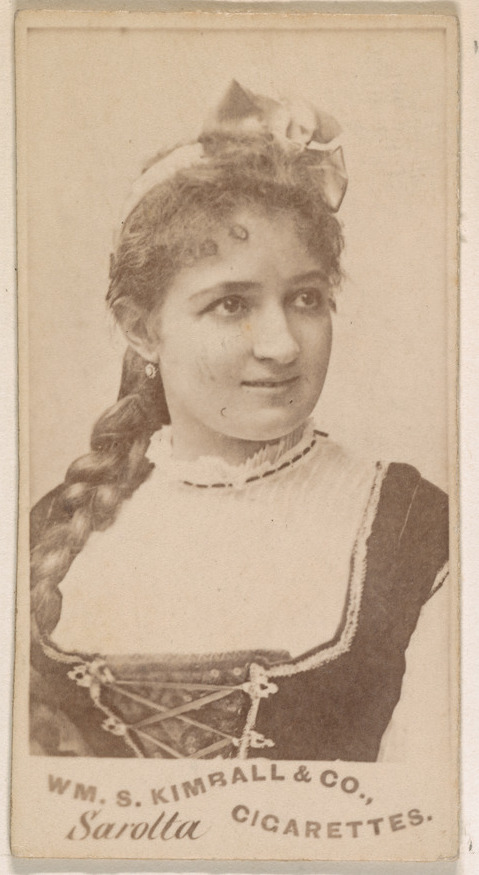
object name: photograph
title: Miss Sarotta, from the Actresses series (N203) issued by Wm. S. Kimball & Co.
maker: william s. kimball & company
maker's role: publisher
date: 1889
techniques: color lithograph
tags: portraits,women,actresses